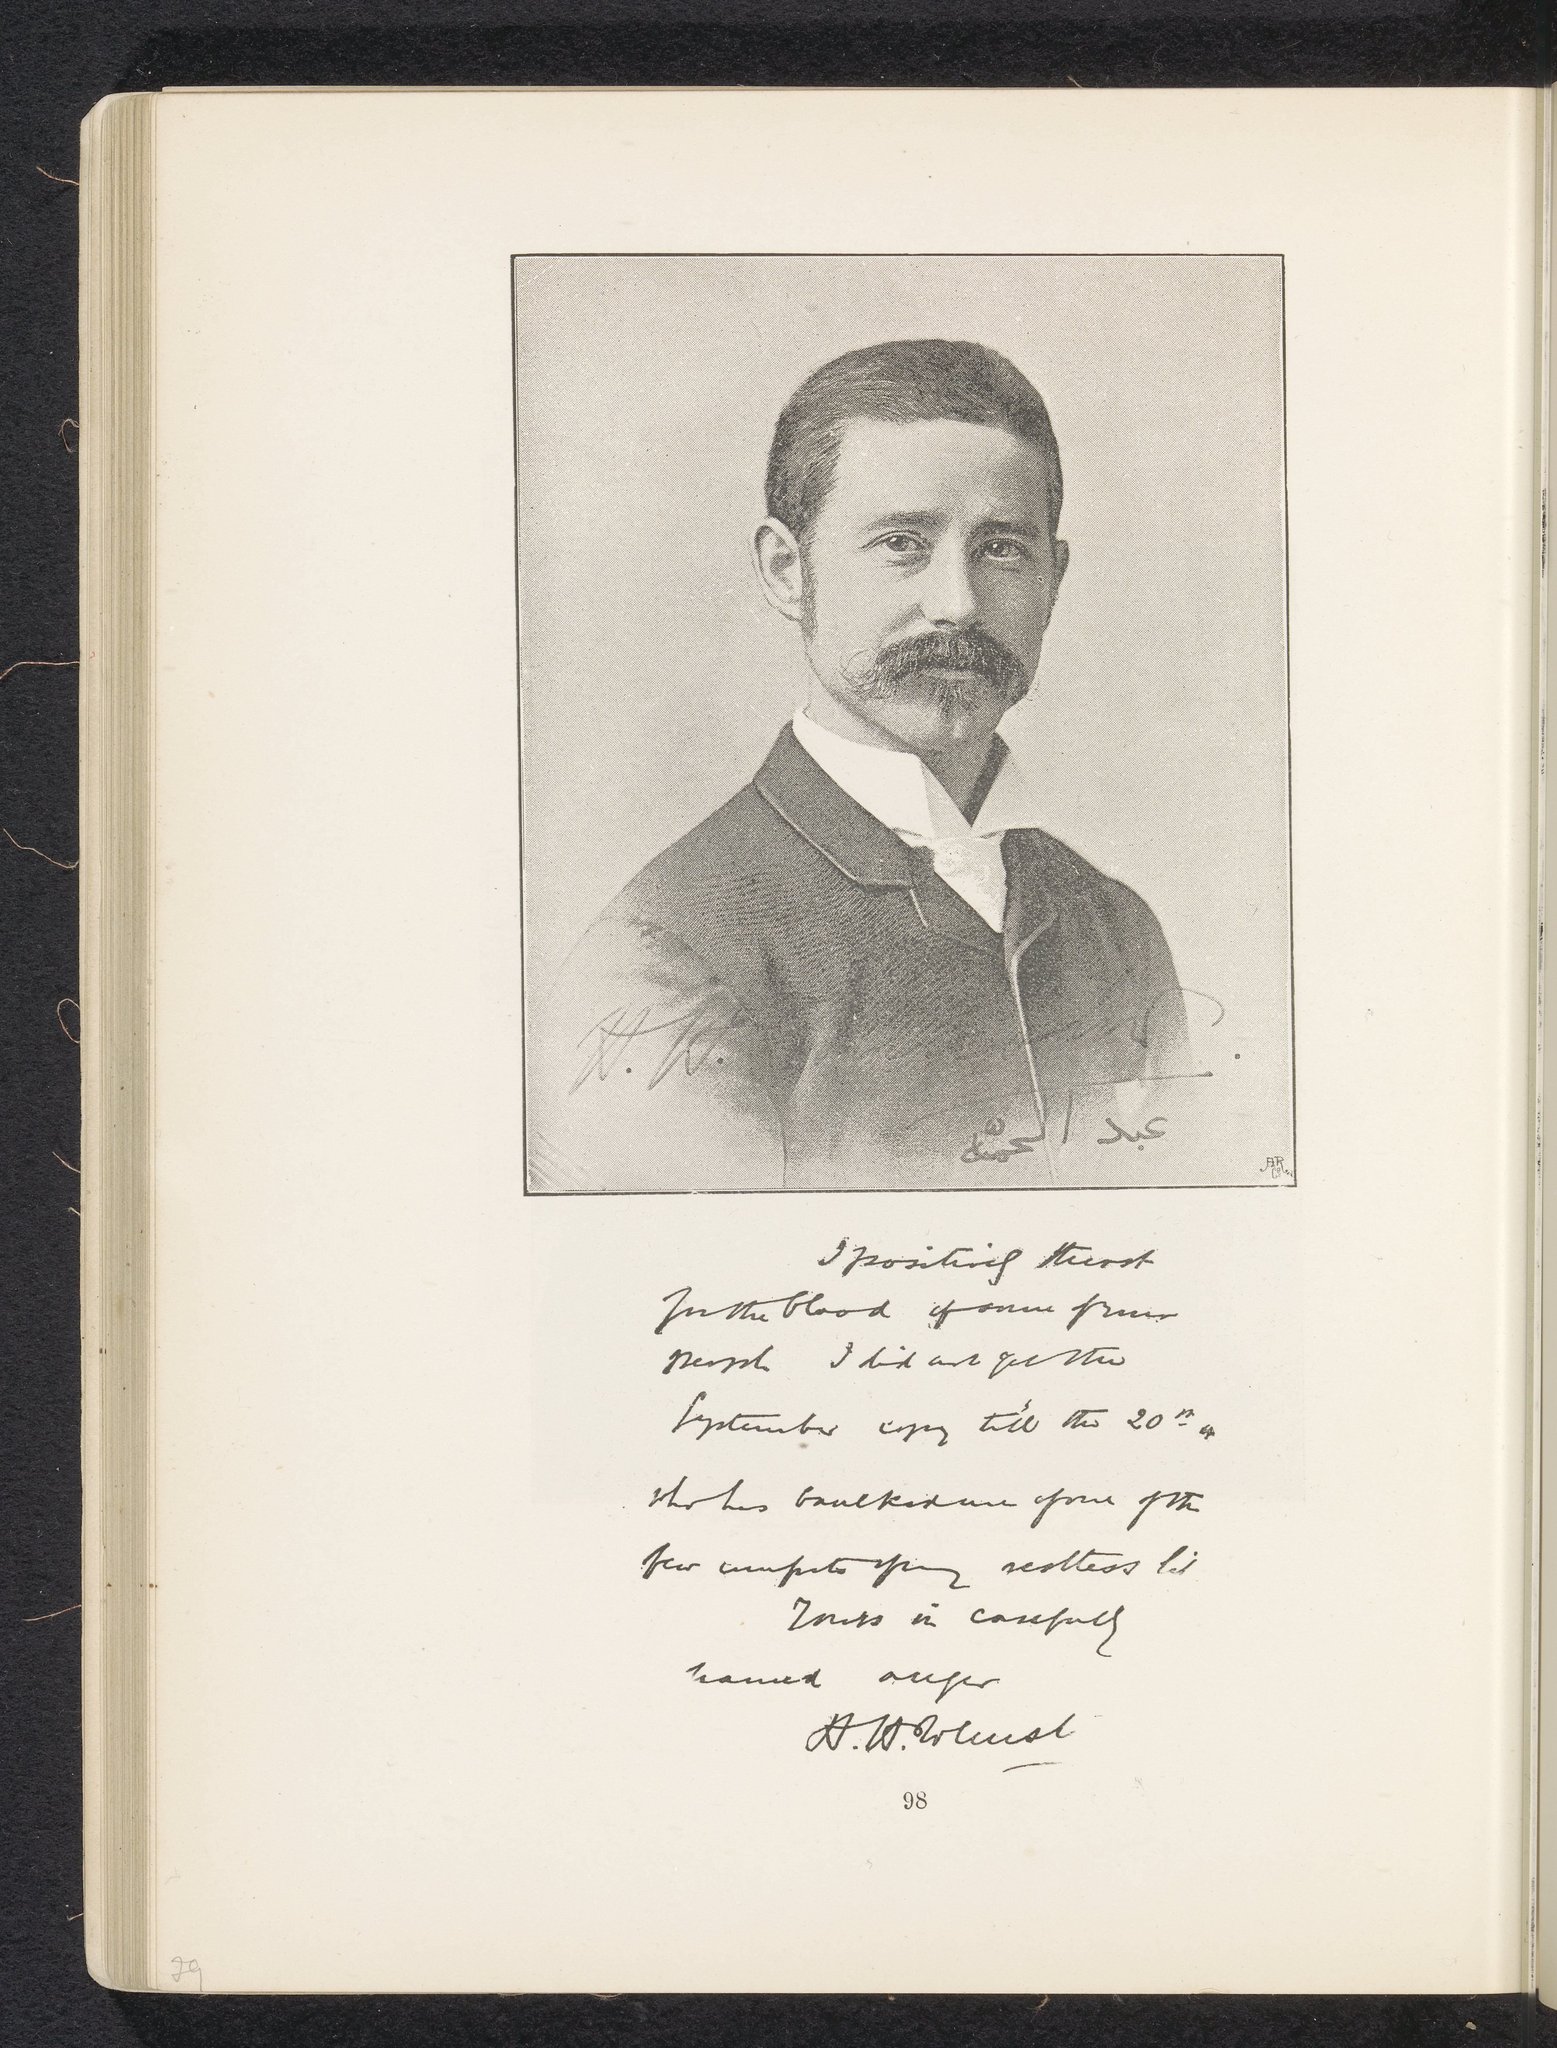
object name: photomechanical print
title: Portret van Harry Johnston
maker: Anonymous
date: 1881-1891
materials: paper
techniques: autotype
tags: explorer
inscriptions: inscription